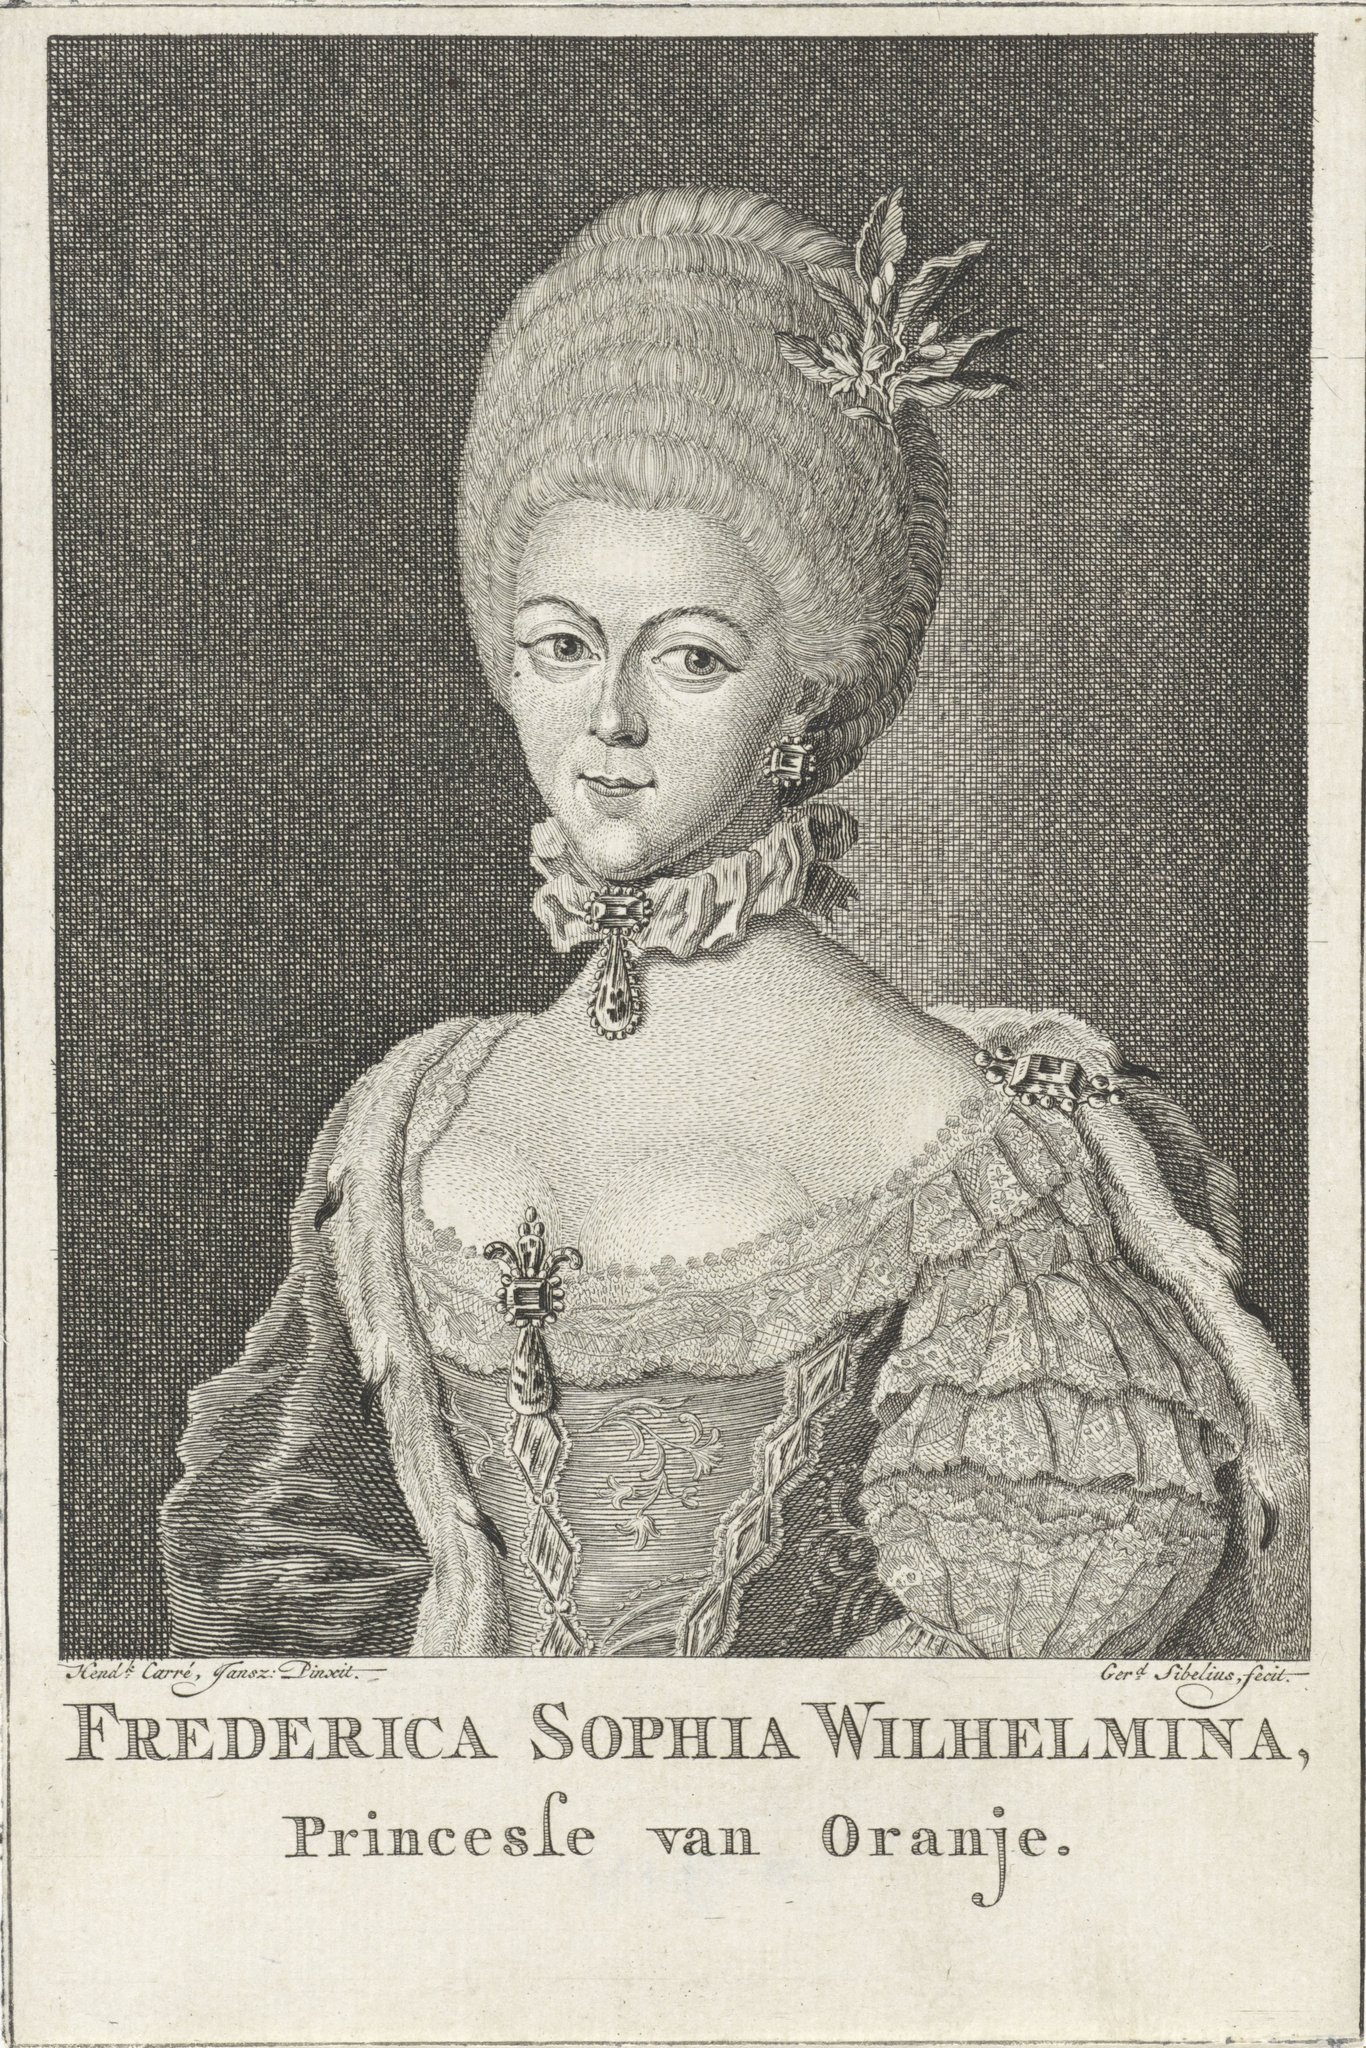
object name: print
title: Portret van Wilhelmina van Pruisen (1751-1820)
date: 1767-1785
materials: paper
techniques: engraving, etching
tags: berlin, painter, draughtsman, wilhelmina of prussia (princess of orange)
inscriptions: collector's mark: Lugt 2228